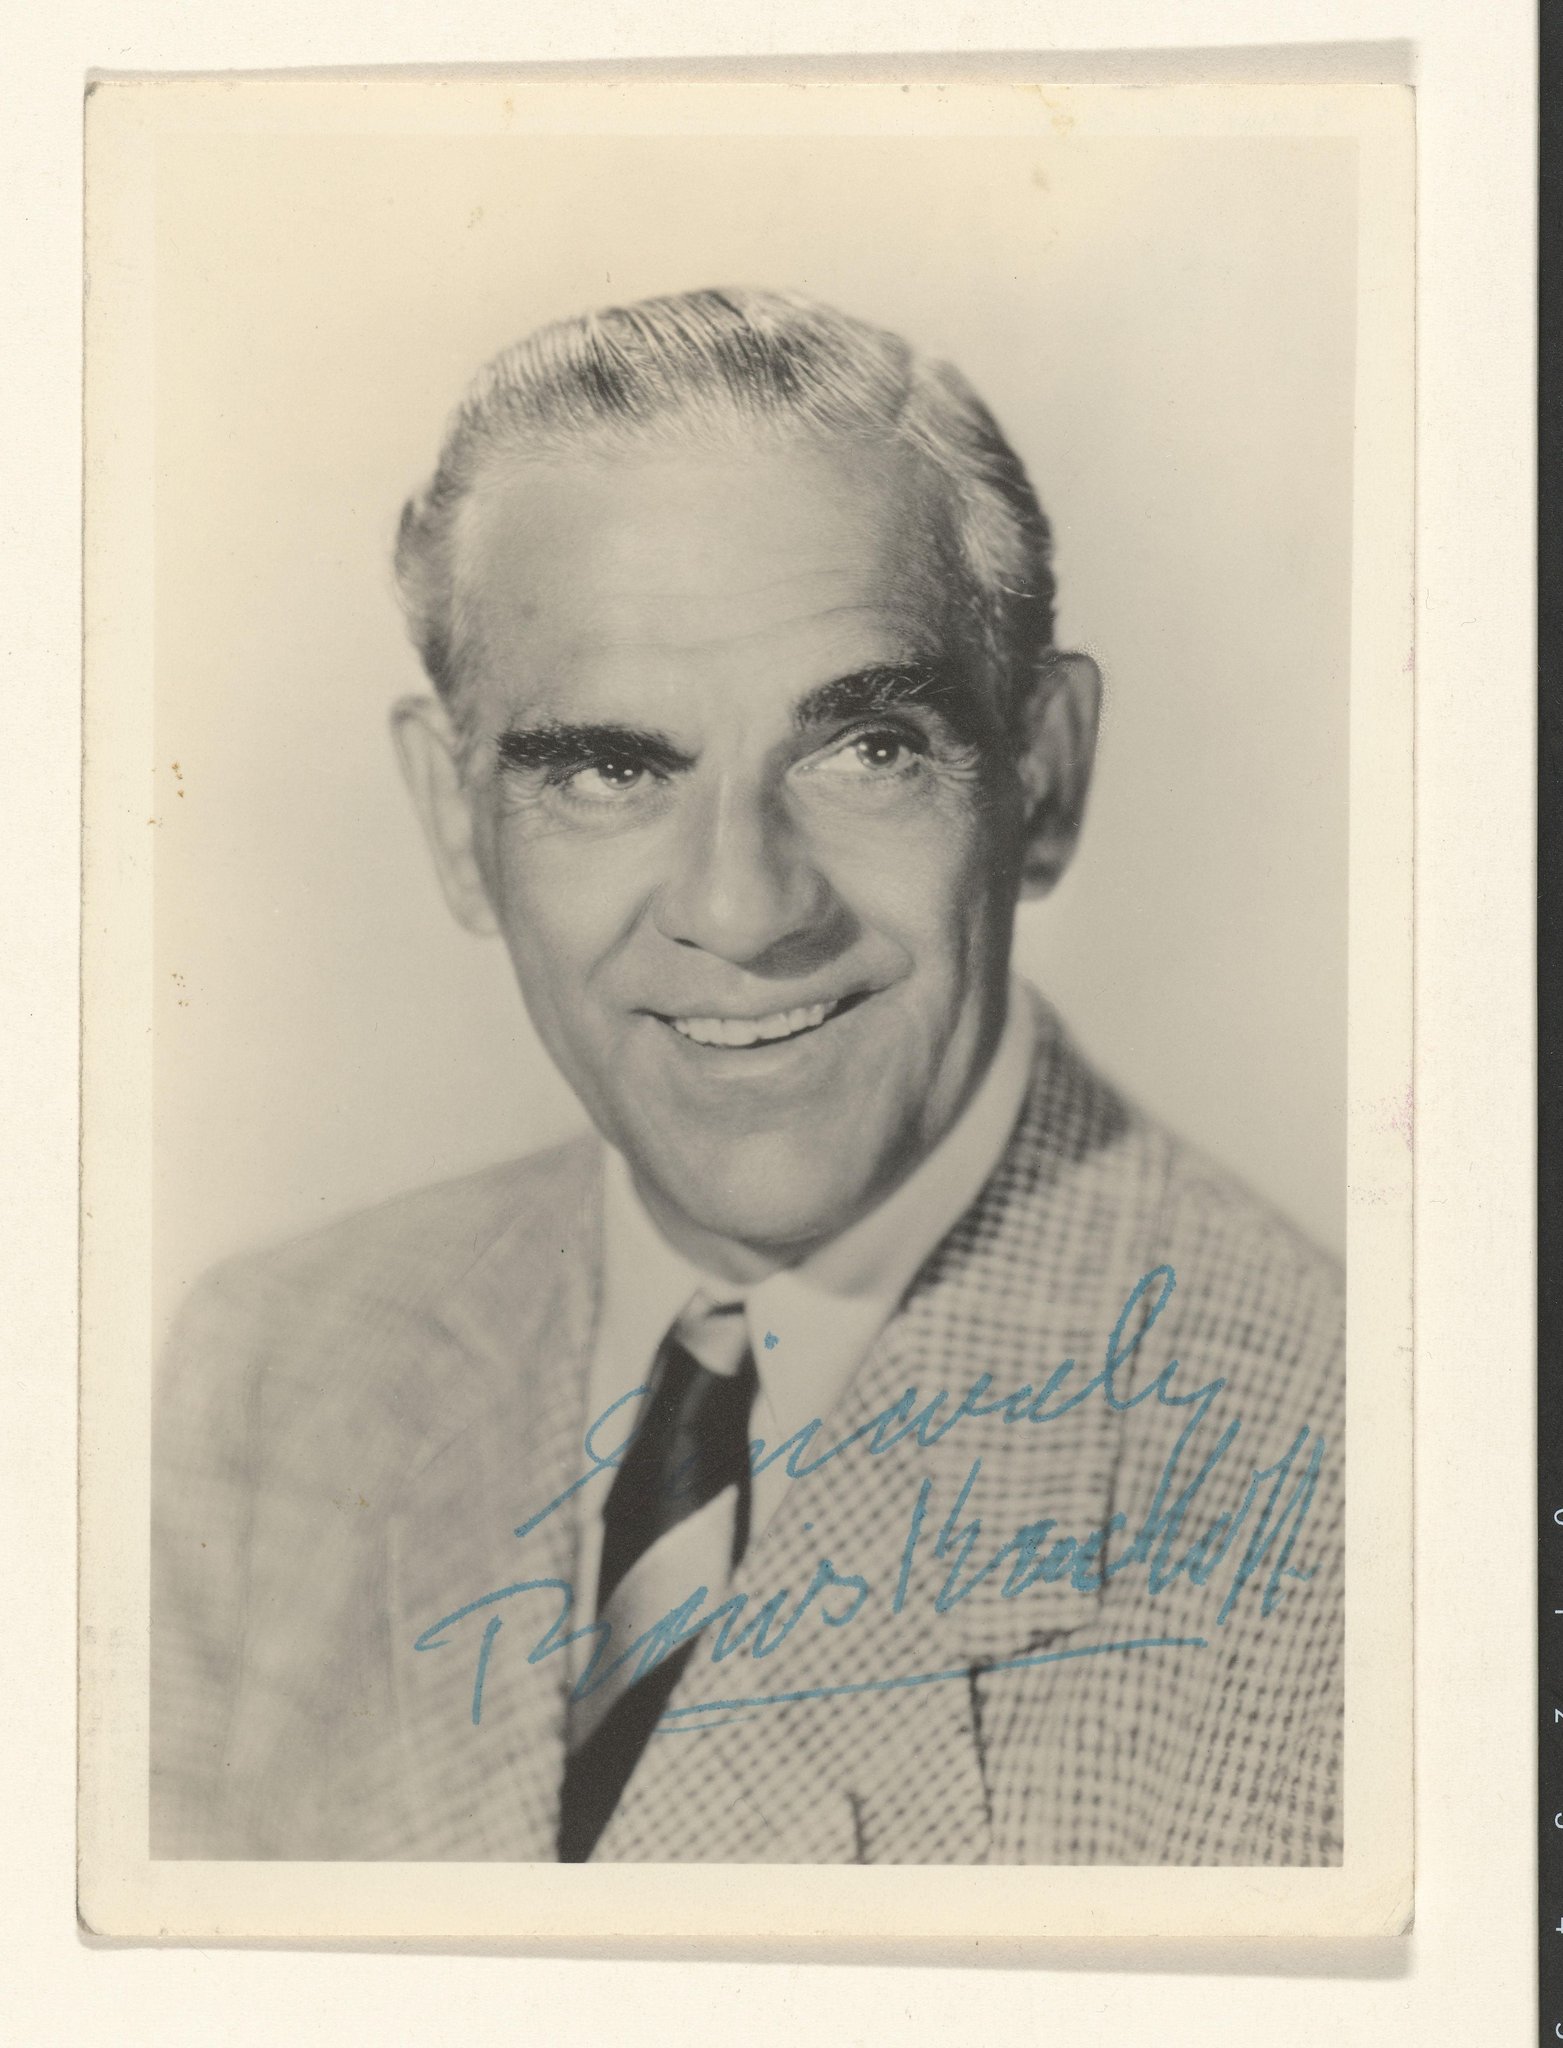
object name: photograph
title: Boris Karloff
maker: Anonymous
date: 1930-1969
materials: photographic support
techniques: gelatin silver print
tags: portrait of film actor, film actress, historical persons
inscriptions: inscription: ‘sincerely Boris Karloff’